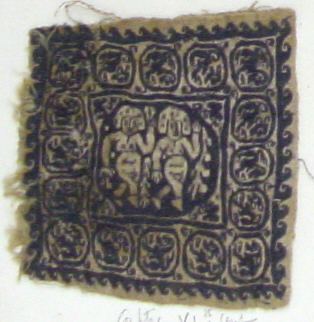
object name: textile fragment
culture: coptic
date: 501-600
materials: linen, wool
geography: egypt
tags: human figures